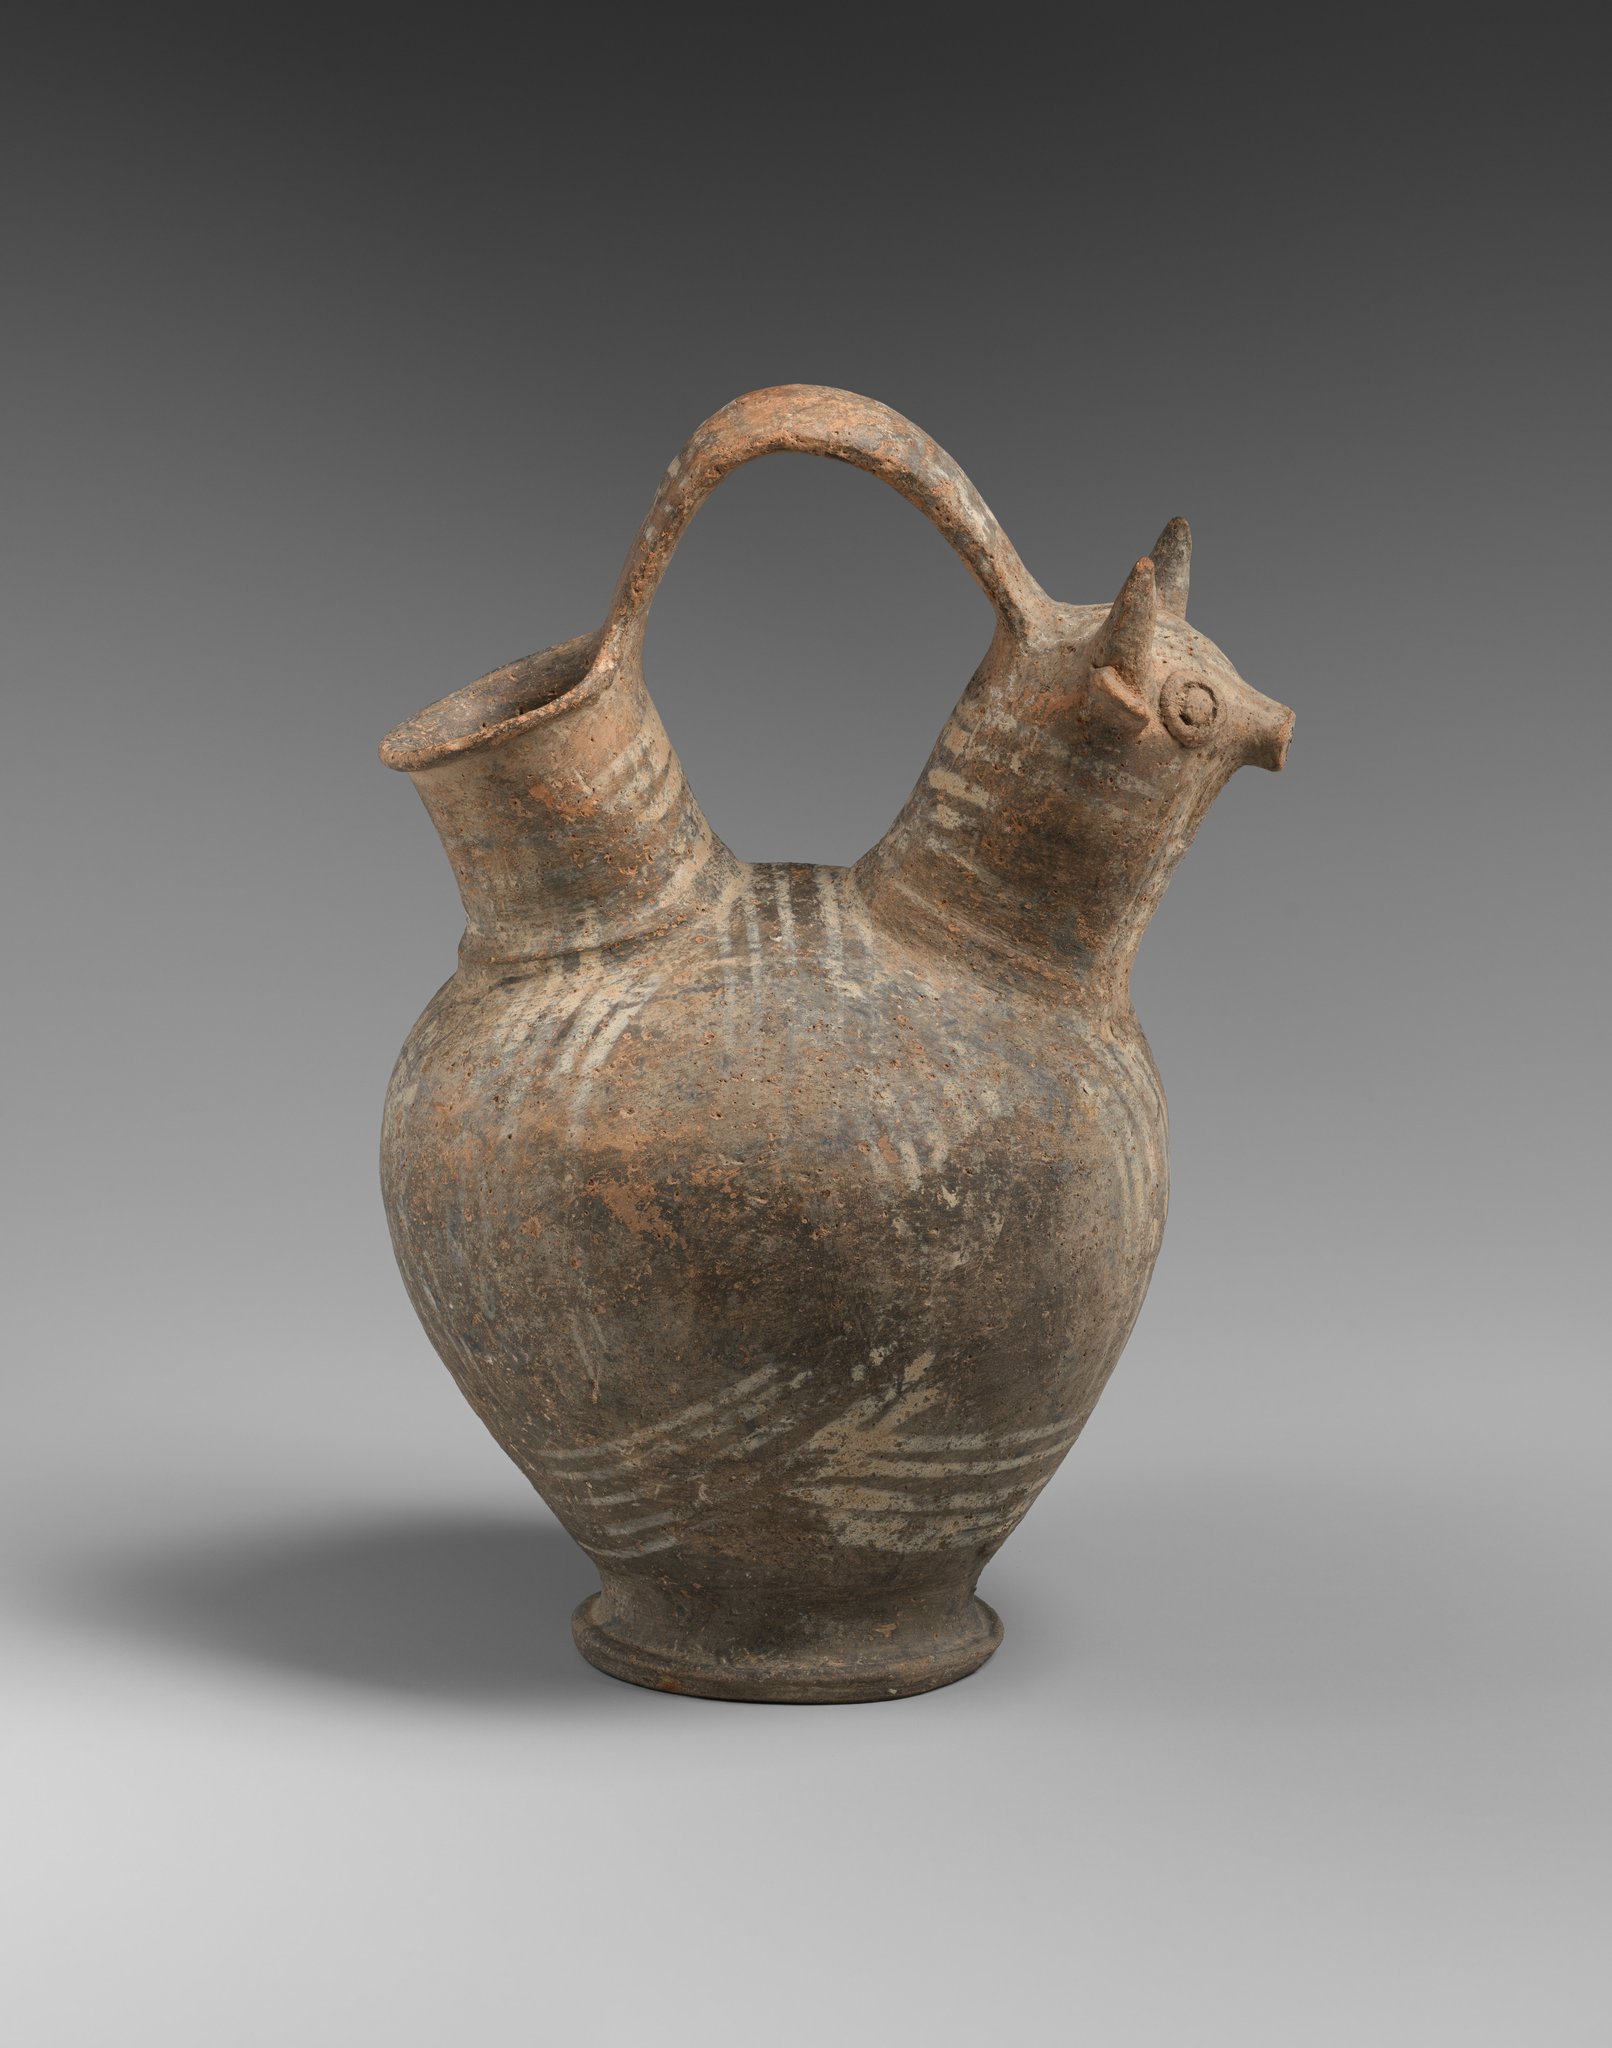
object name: askos with bull protome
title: Terracotta askos (vessel) with bull protome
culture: cypriot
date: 1450-1200 BCE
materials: terracotta